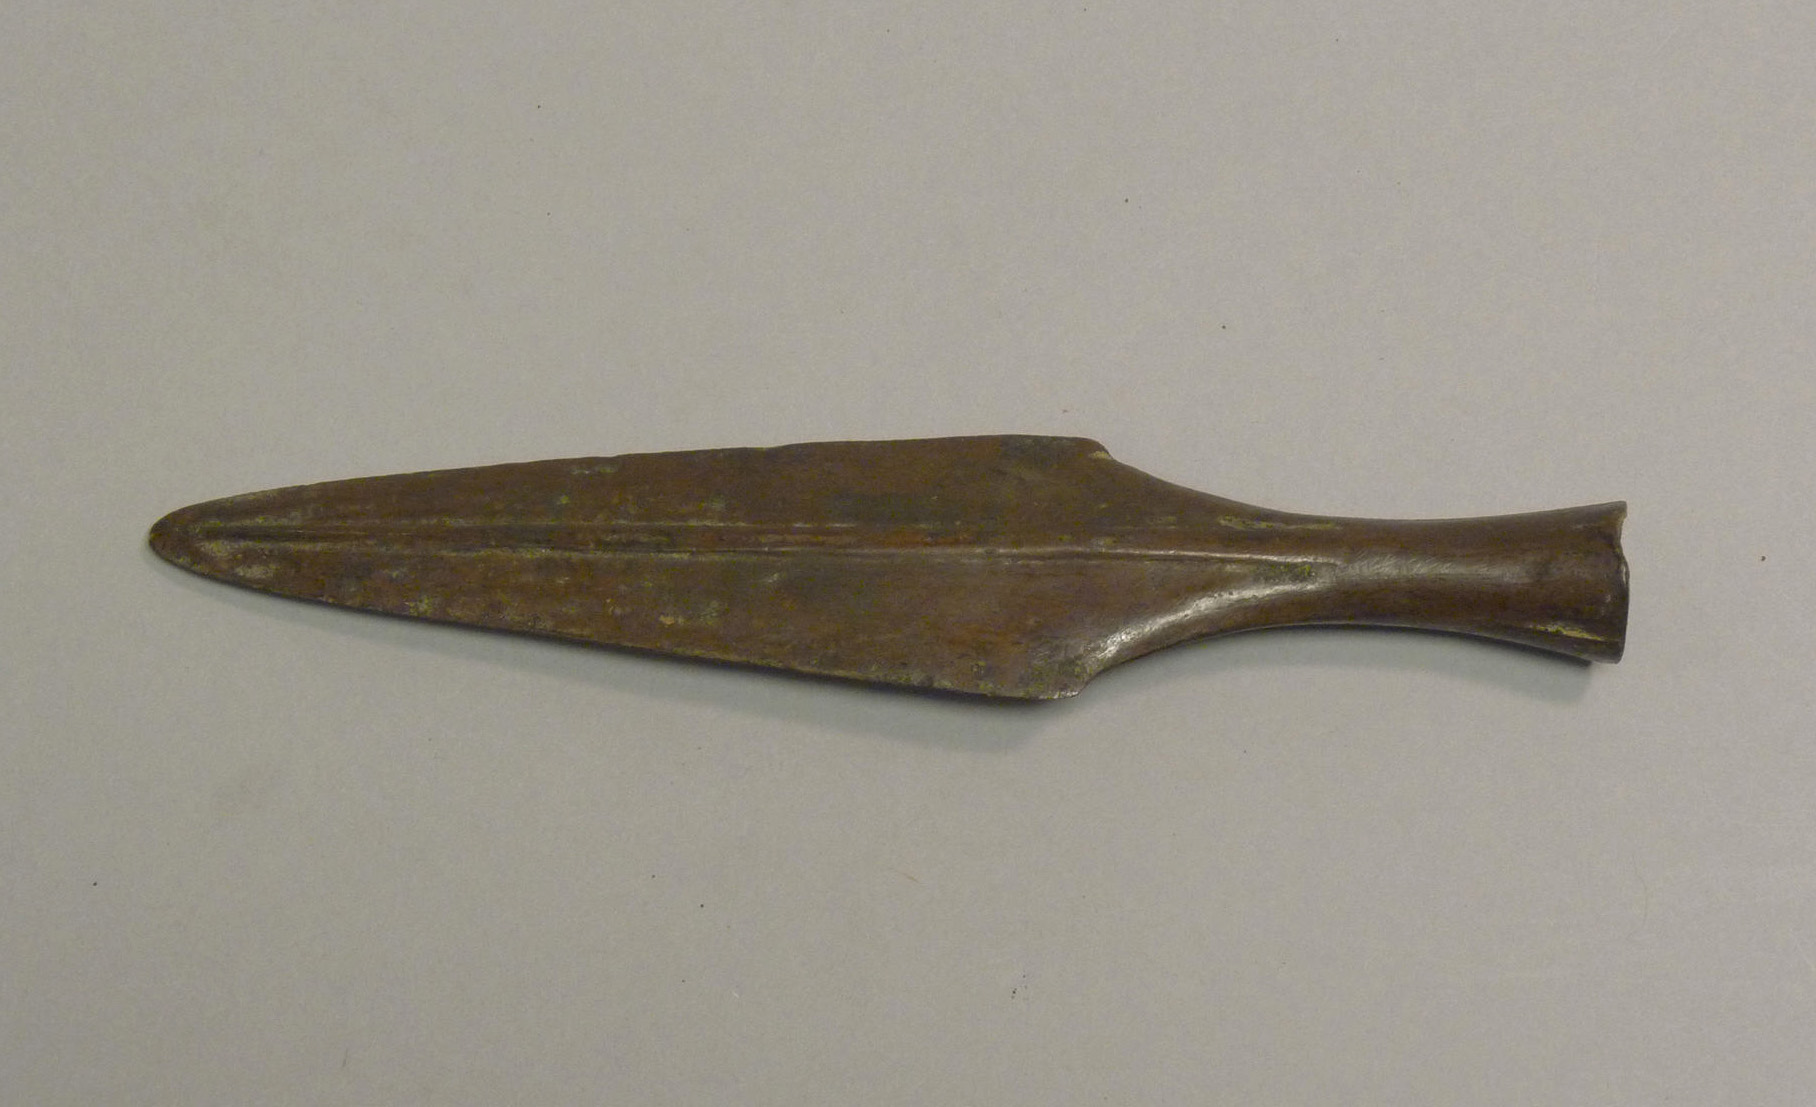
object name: spearhead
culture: vietnamese, dong son culture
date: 500 BCE-300 CE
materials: bronze